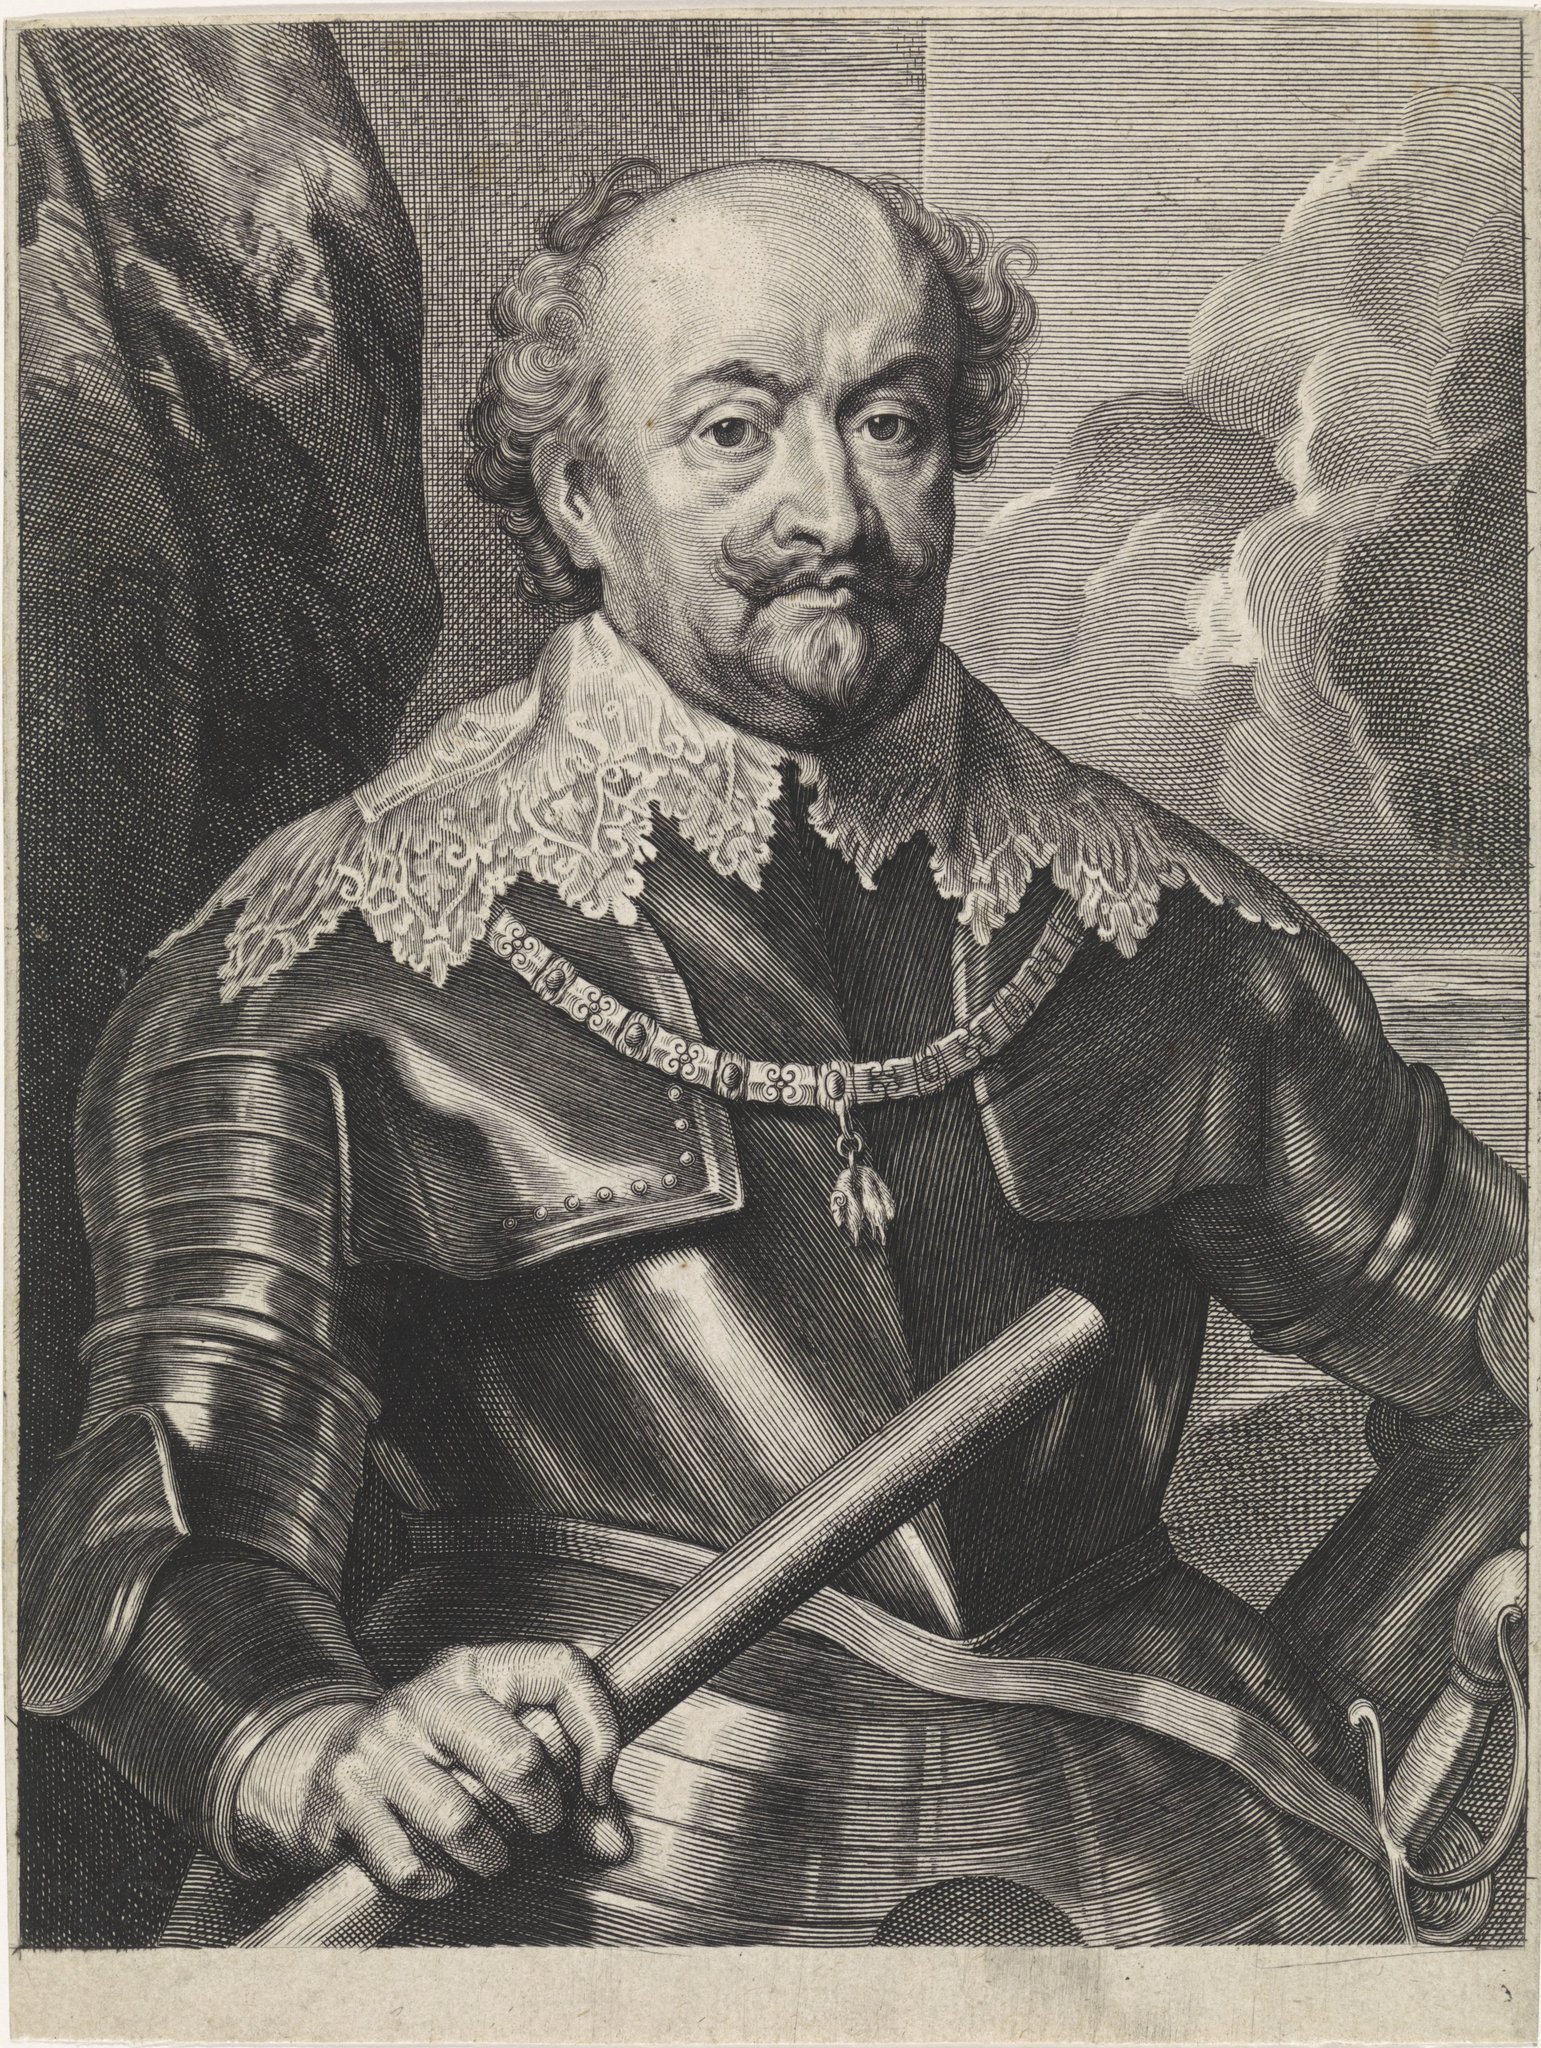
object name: print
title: Portret van Jan de Jongste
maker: paulus pontius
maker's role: draughtsman, print maker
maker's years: 1603-1658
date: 1616-1657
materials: paper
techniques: engraving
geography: antwerp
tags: armour, knighthood order of the golden fleece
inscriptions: collector's mark: Lugt 240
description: Portret van Jan de Jongste, graaf van Nassau, Katzenelnbogen, Vianden en Dietz. Hij draagt een keten met de Orde van het Gulden Vlies.